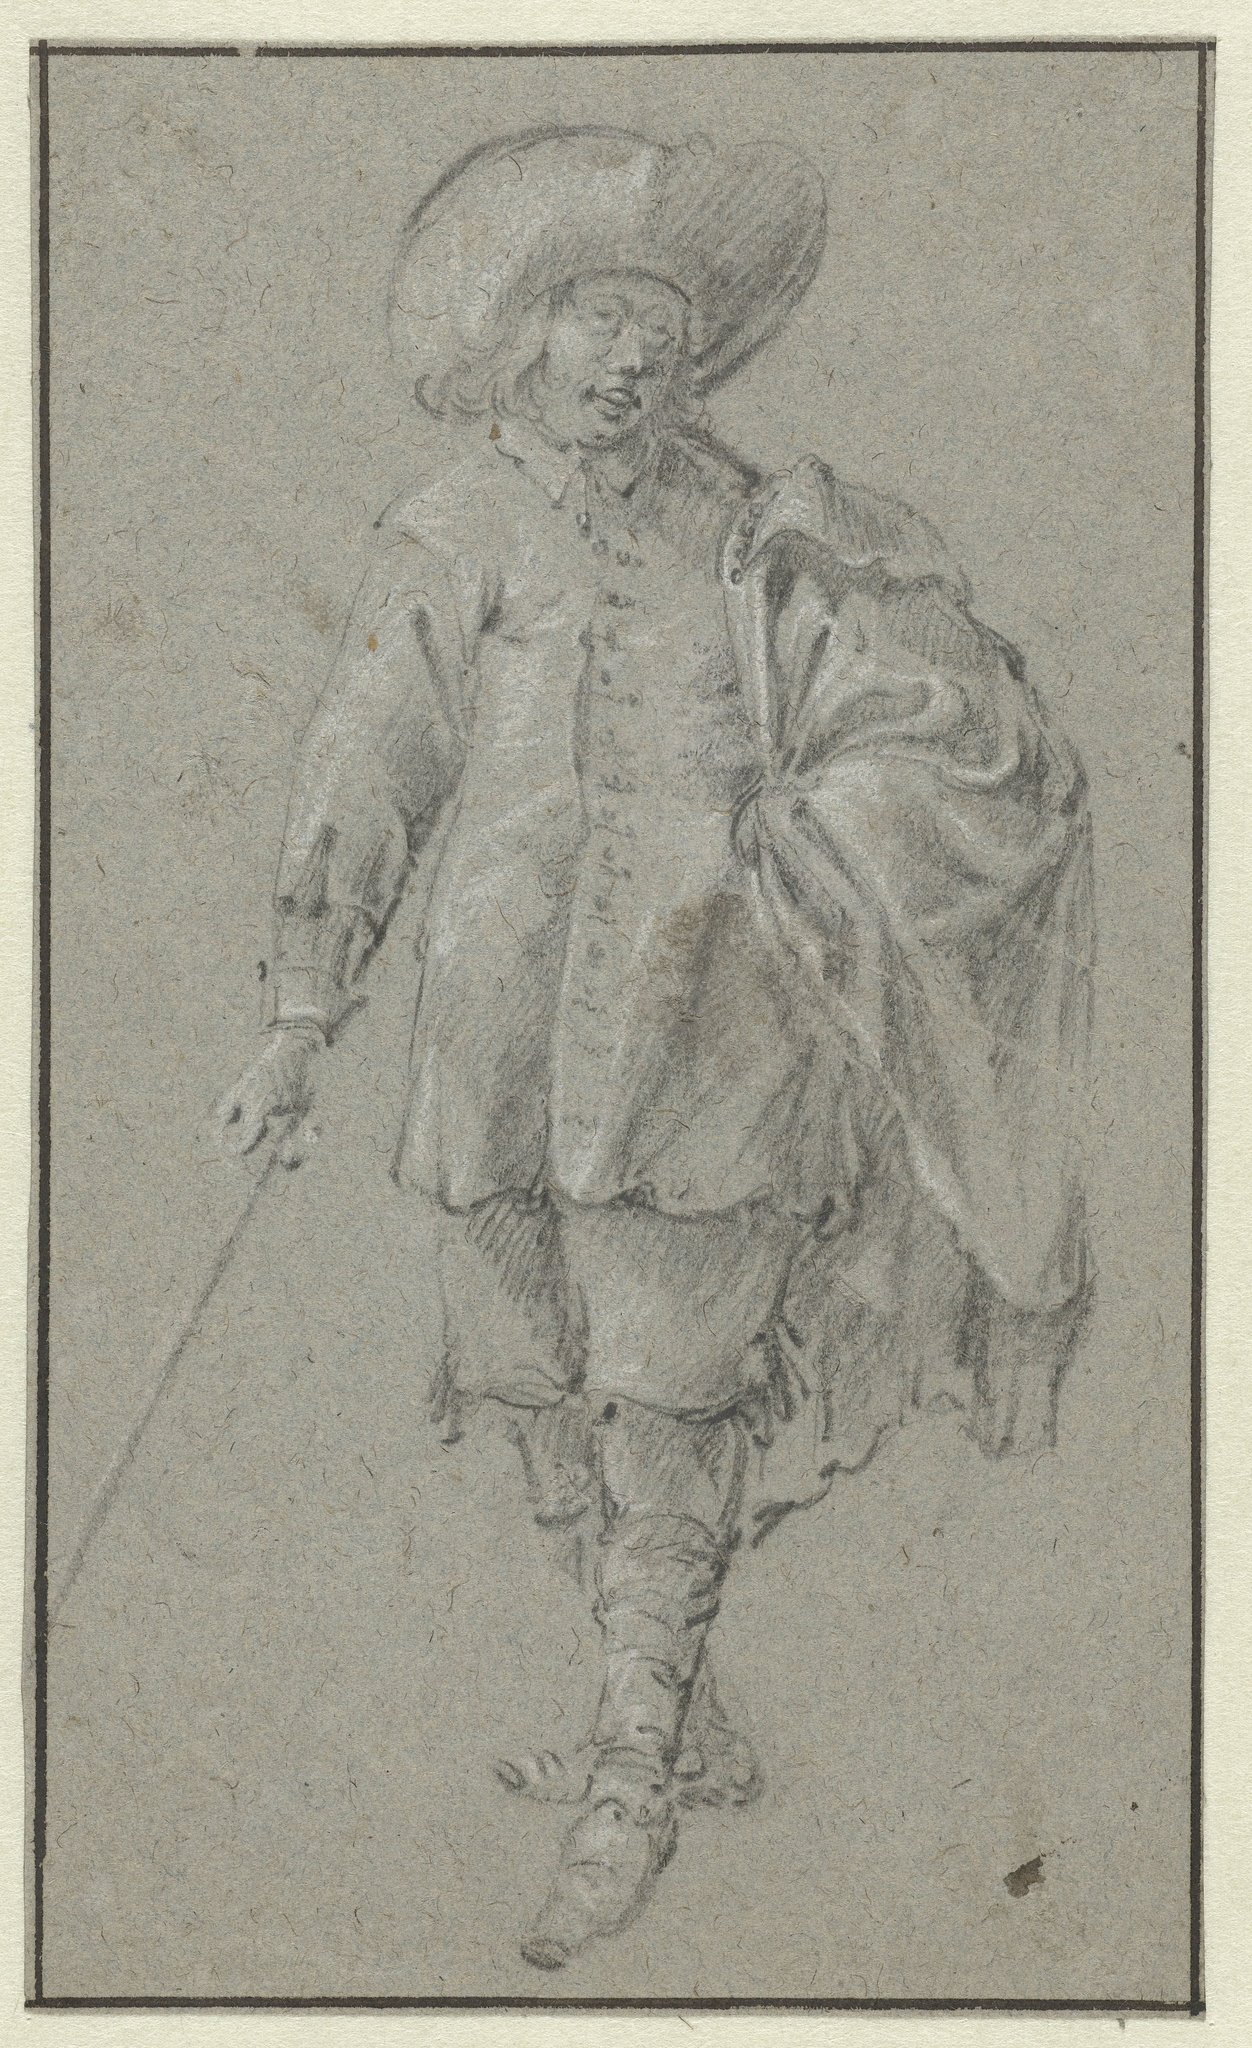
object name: drawing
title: Staande jongeman, ten voeten uit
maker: Anonymous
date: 1600-1699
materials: paper, chalk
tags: standing figure